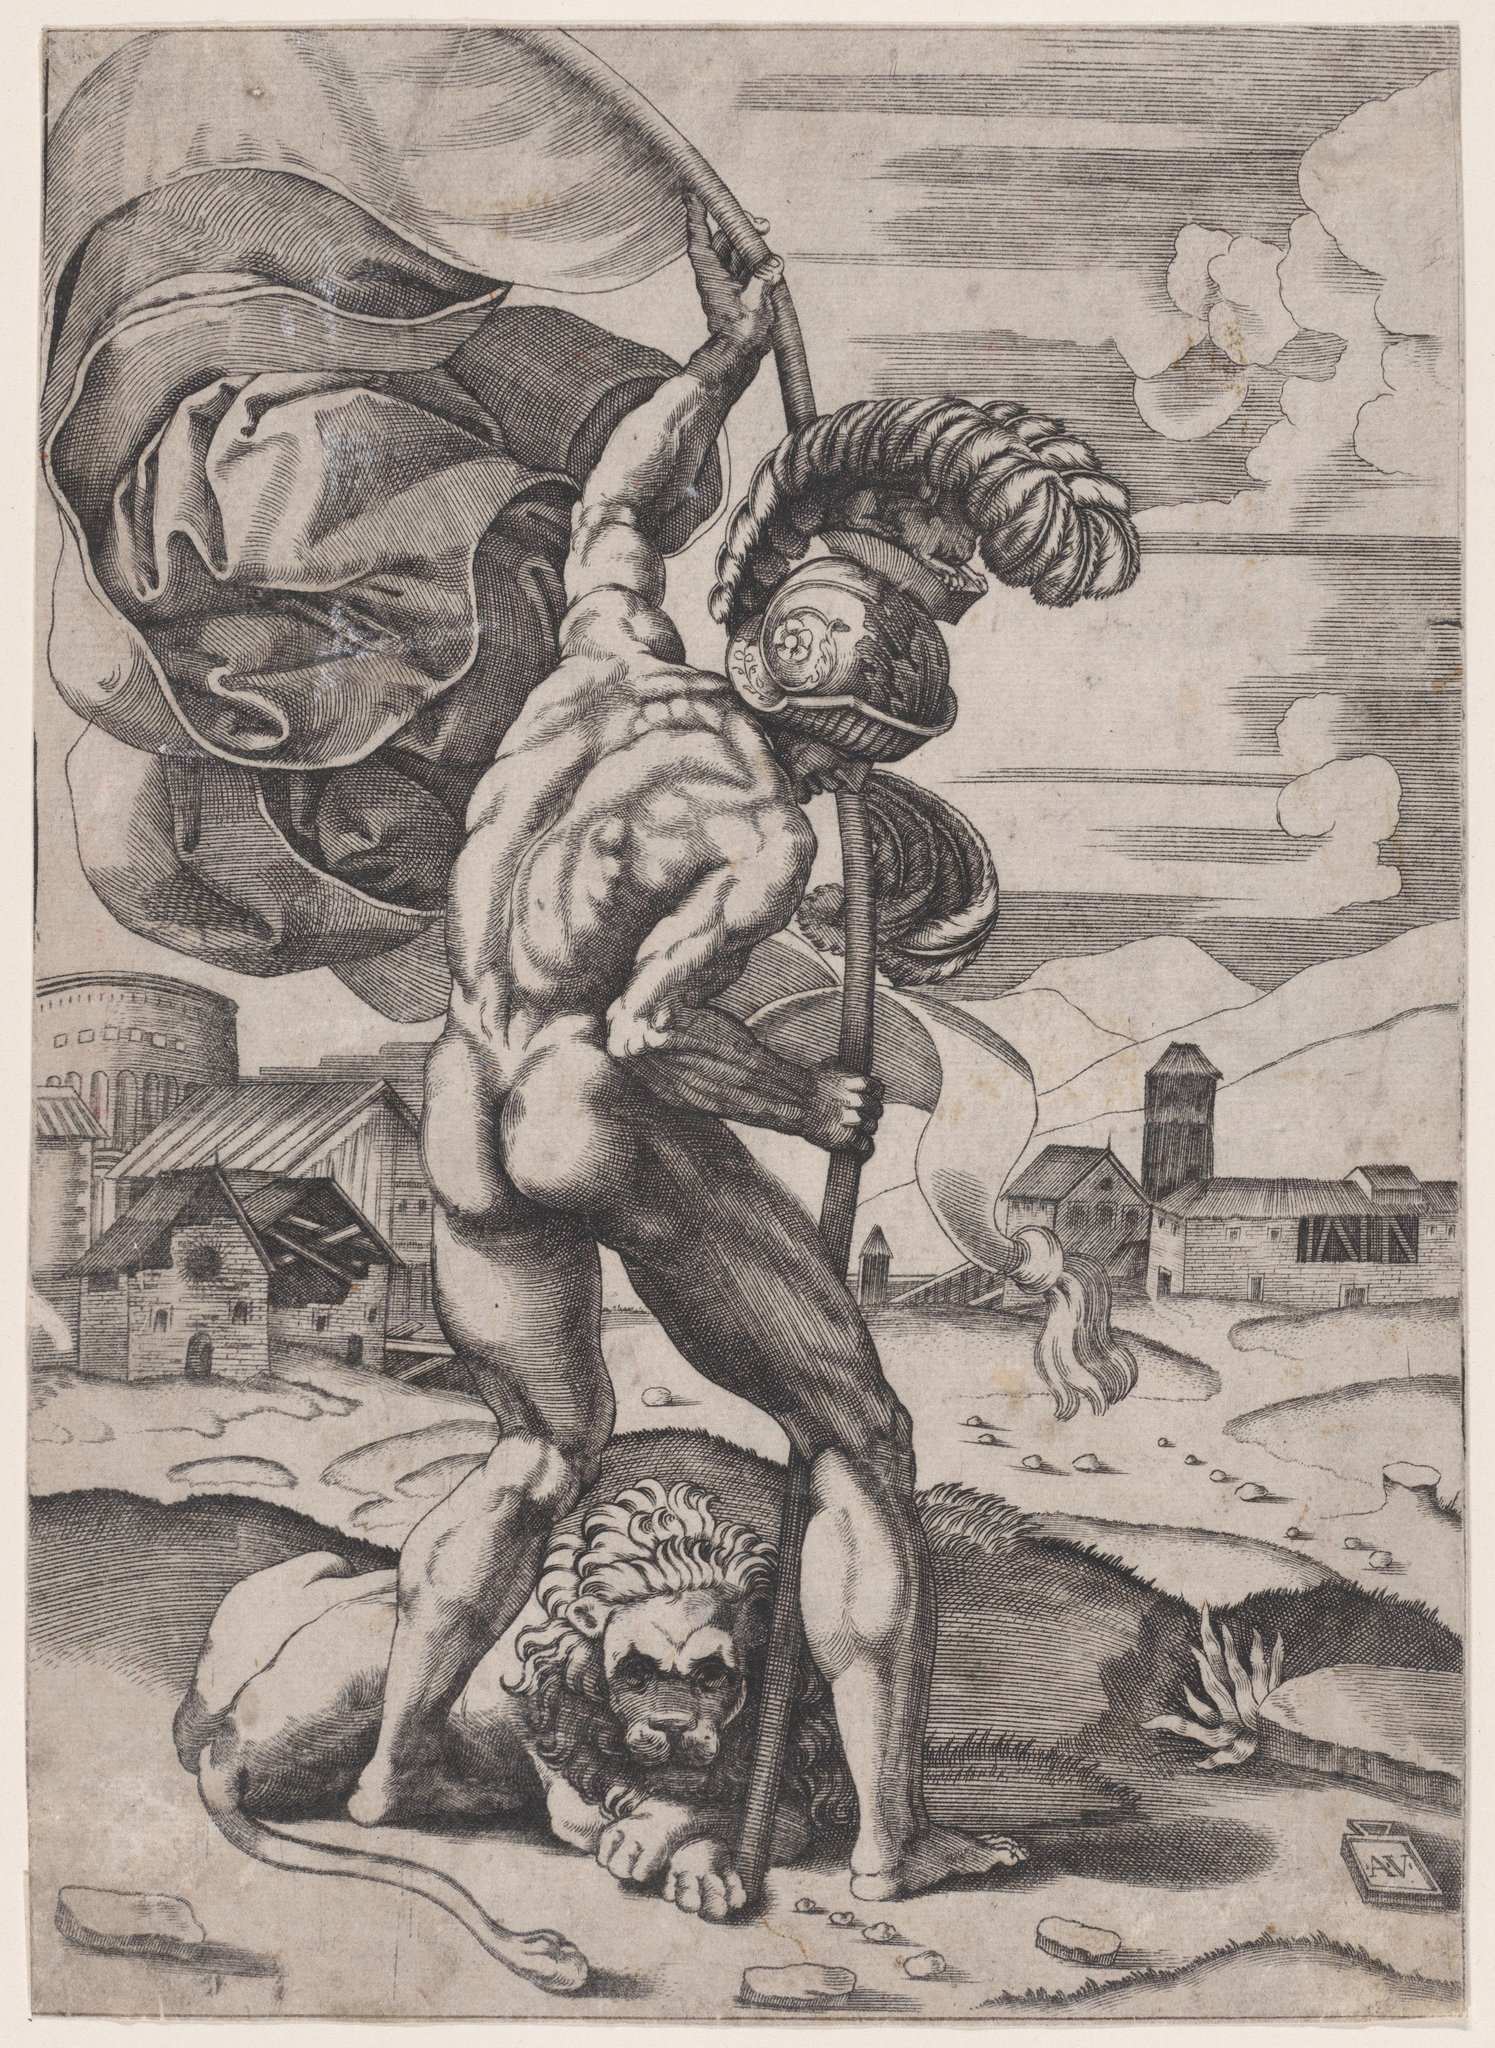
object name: print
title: Man with a Flag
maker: agostino veneziano (agostino dei musi)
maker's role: artist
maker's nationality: italian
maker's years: 1490-1536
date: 1514-1536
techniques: engraving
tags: male nudes,lions,flags